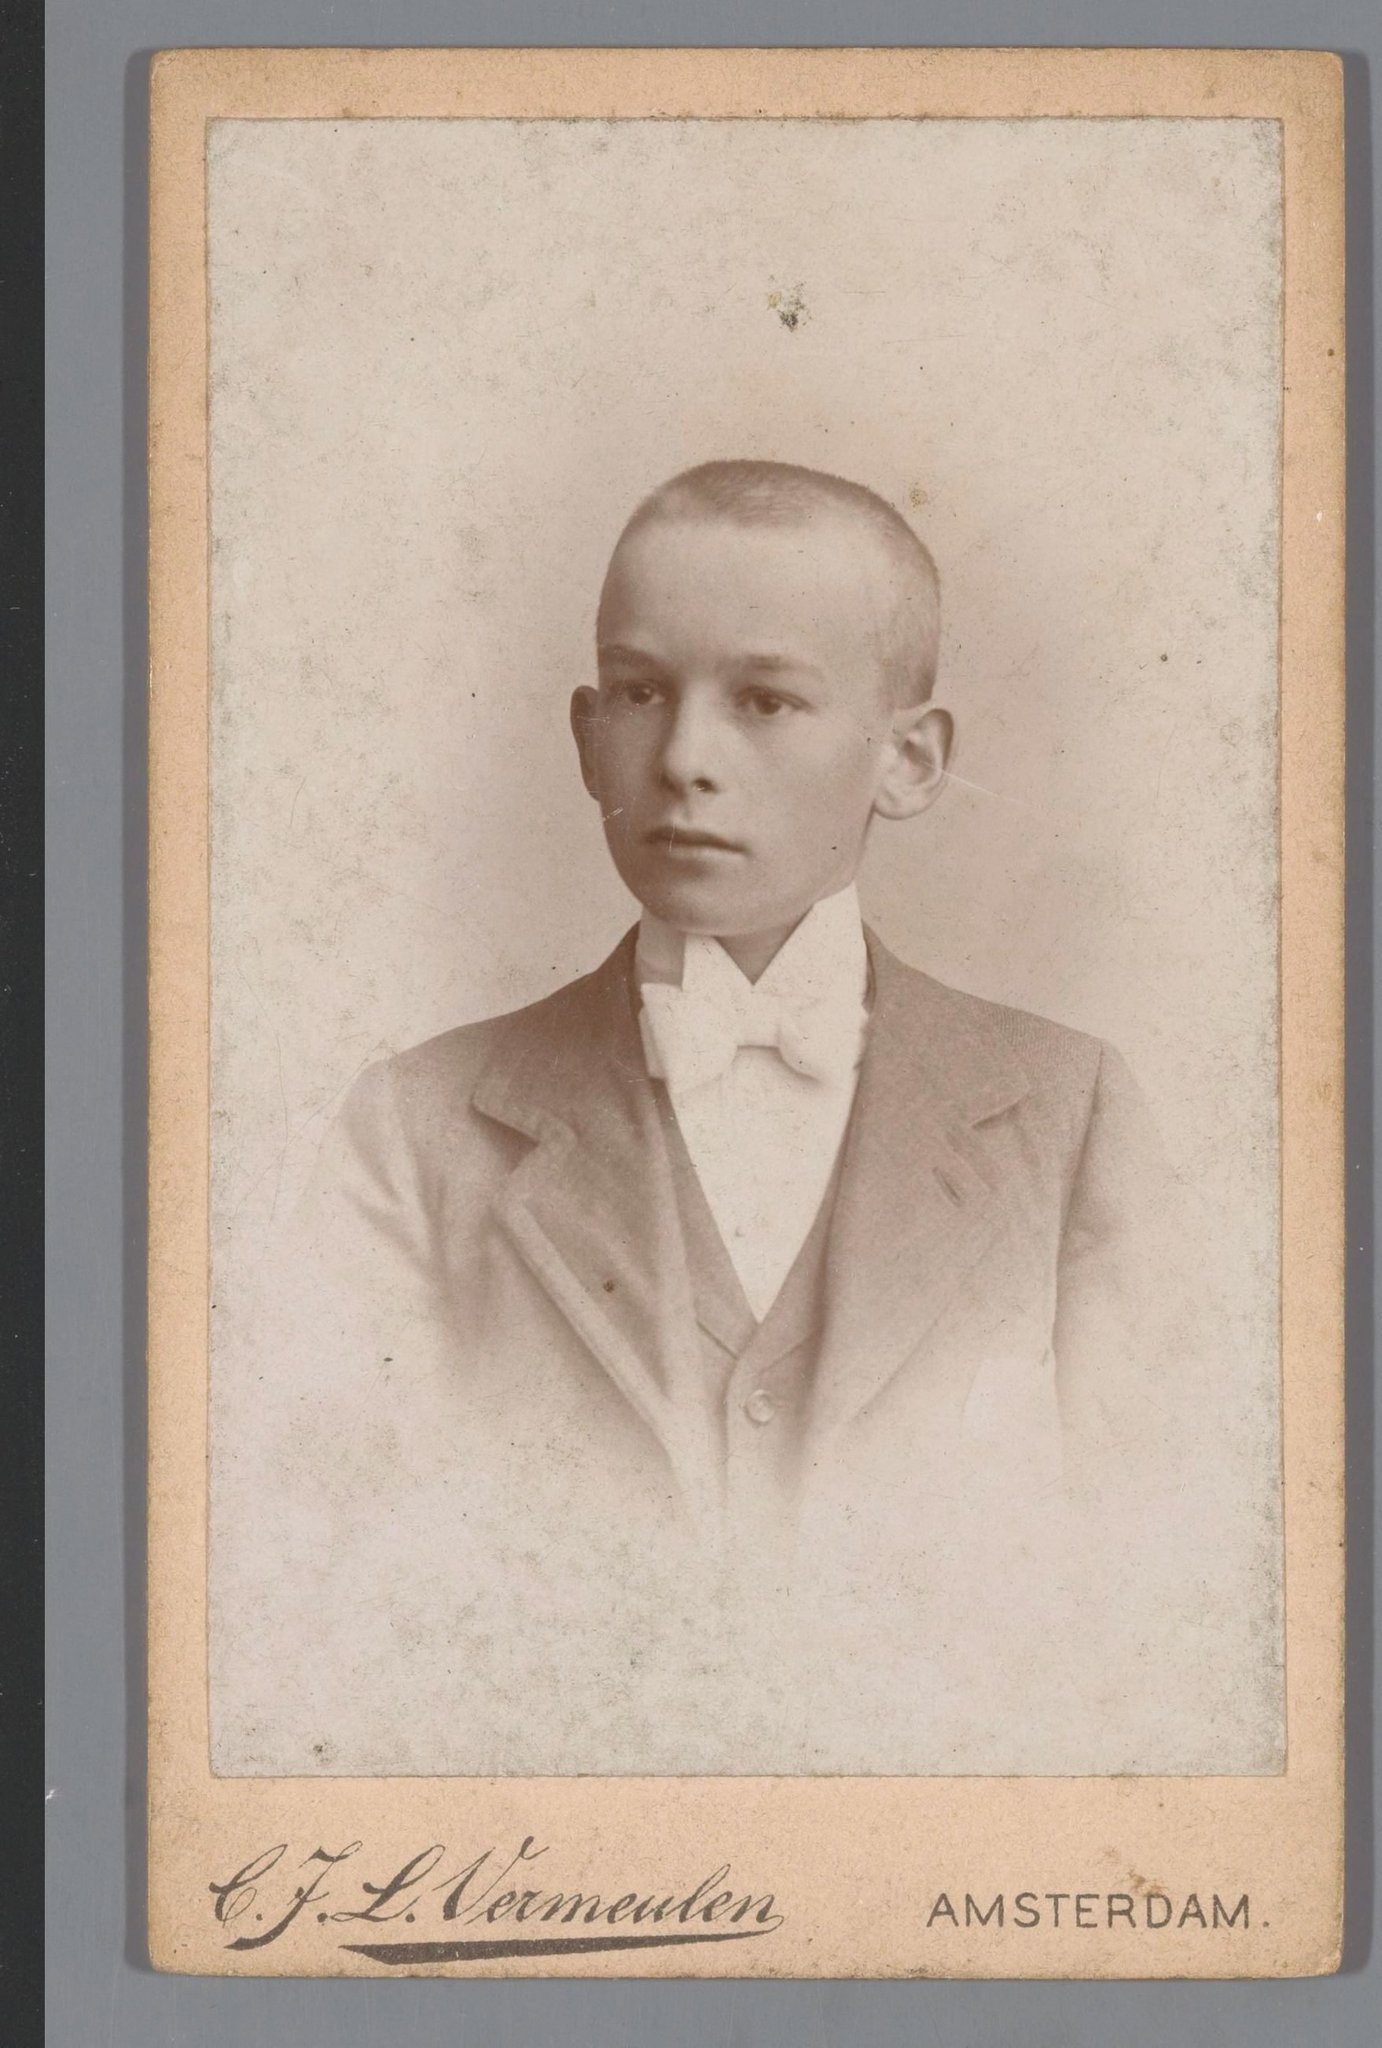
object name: carte de visite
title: Portret van een onbekende jongen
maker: cornelis johannes lodewicus vermeulen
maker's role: fotograaf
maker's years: 1861-1936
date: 1878-1896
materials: cardboard, photographic support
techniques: collodion silver print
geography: amsterdam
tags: boy (child between toddler and youth)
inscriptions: name: ‘C.J.L. Vermeulen Photographische Ateliers. Amsterdam Heerenstraat 6 & Heiligenweg hoek Singel. Specialiteit in vergrootingen’